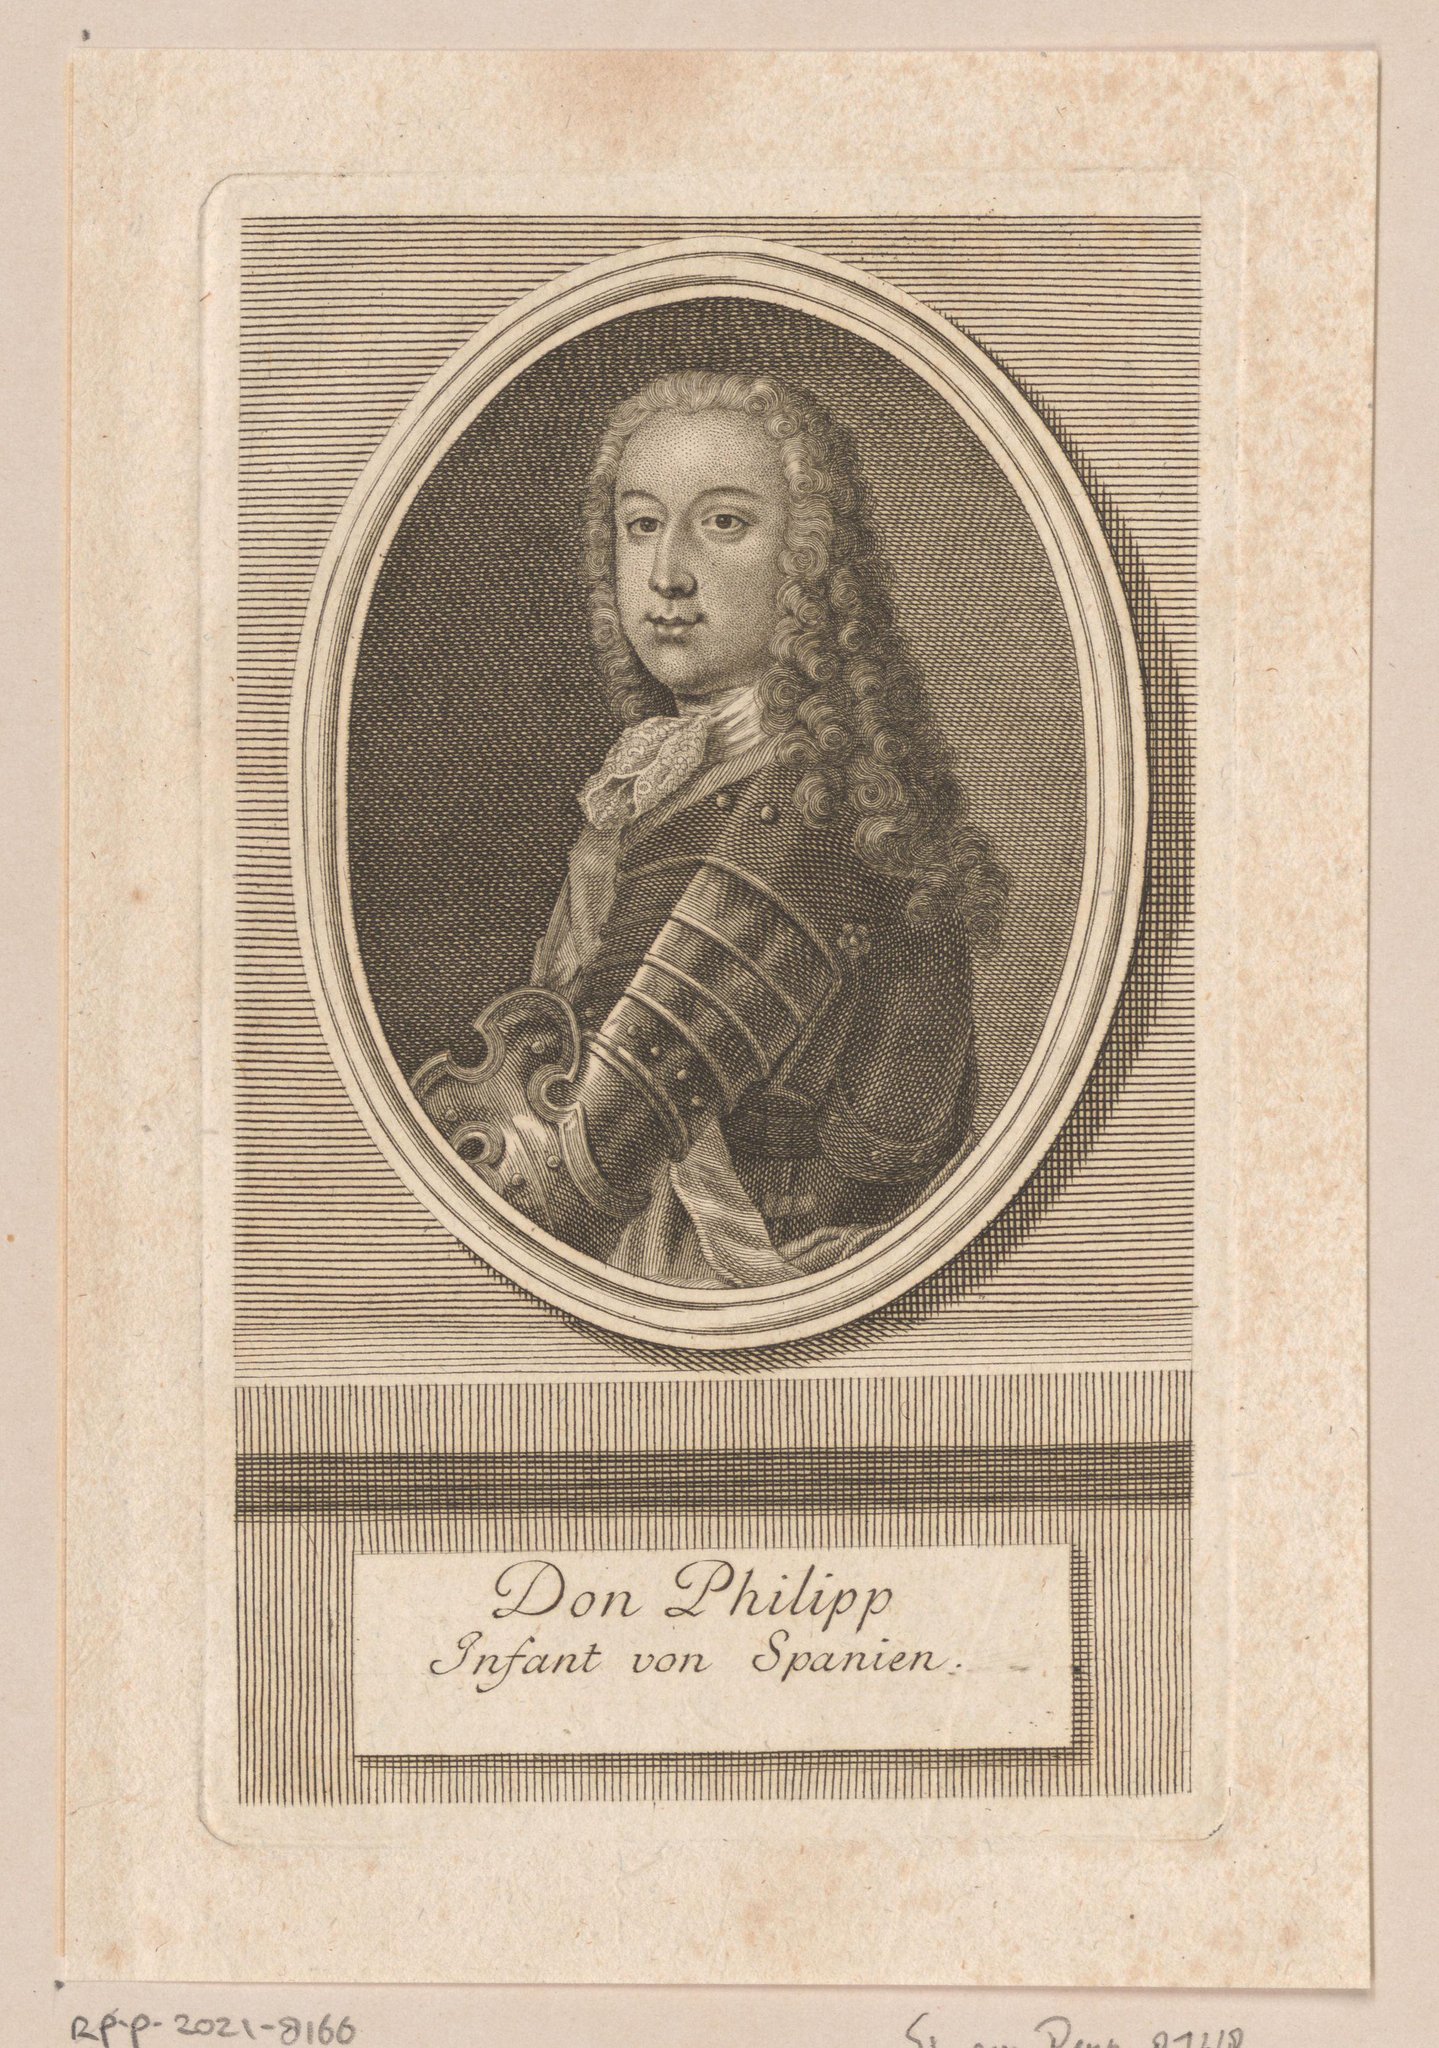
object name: print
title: Portret van Filips, hertog van Parma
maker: Anonymous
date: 1730-1799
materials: paper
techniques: engraving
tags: adult man, historical persons